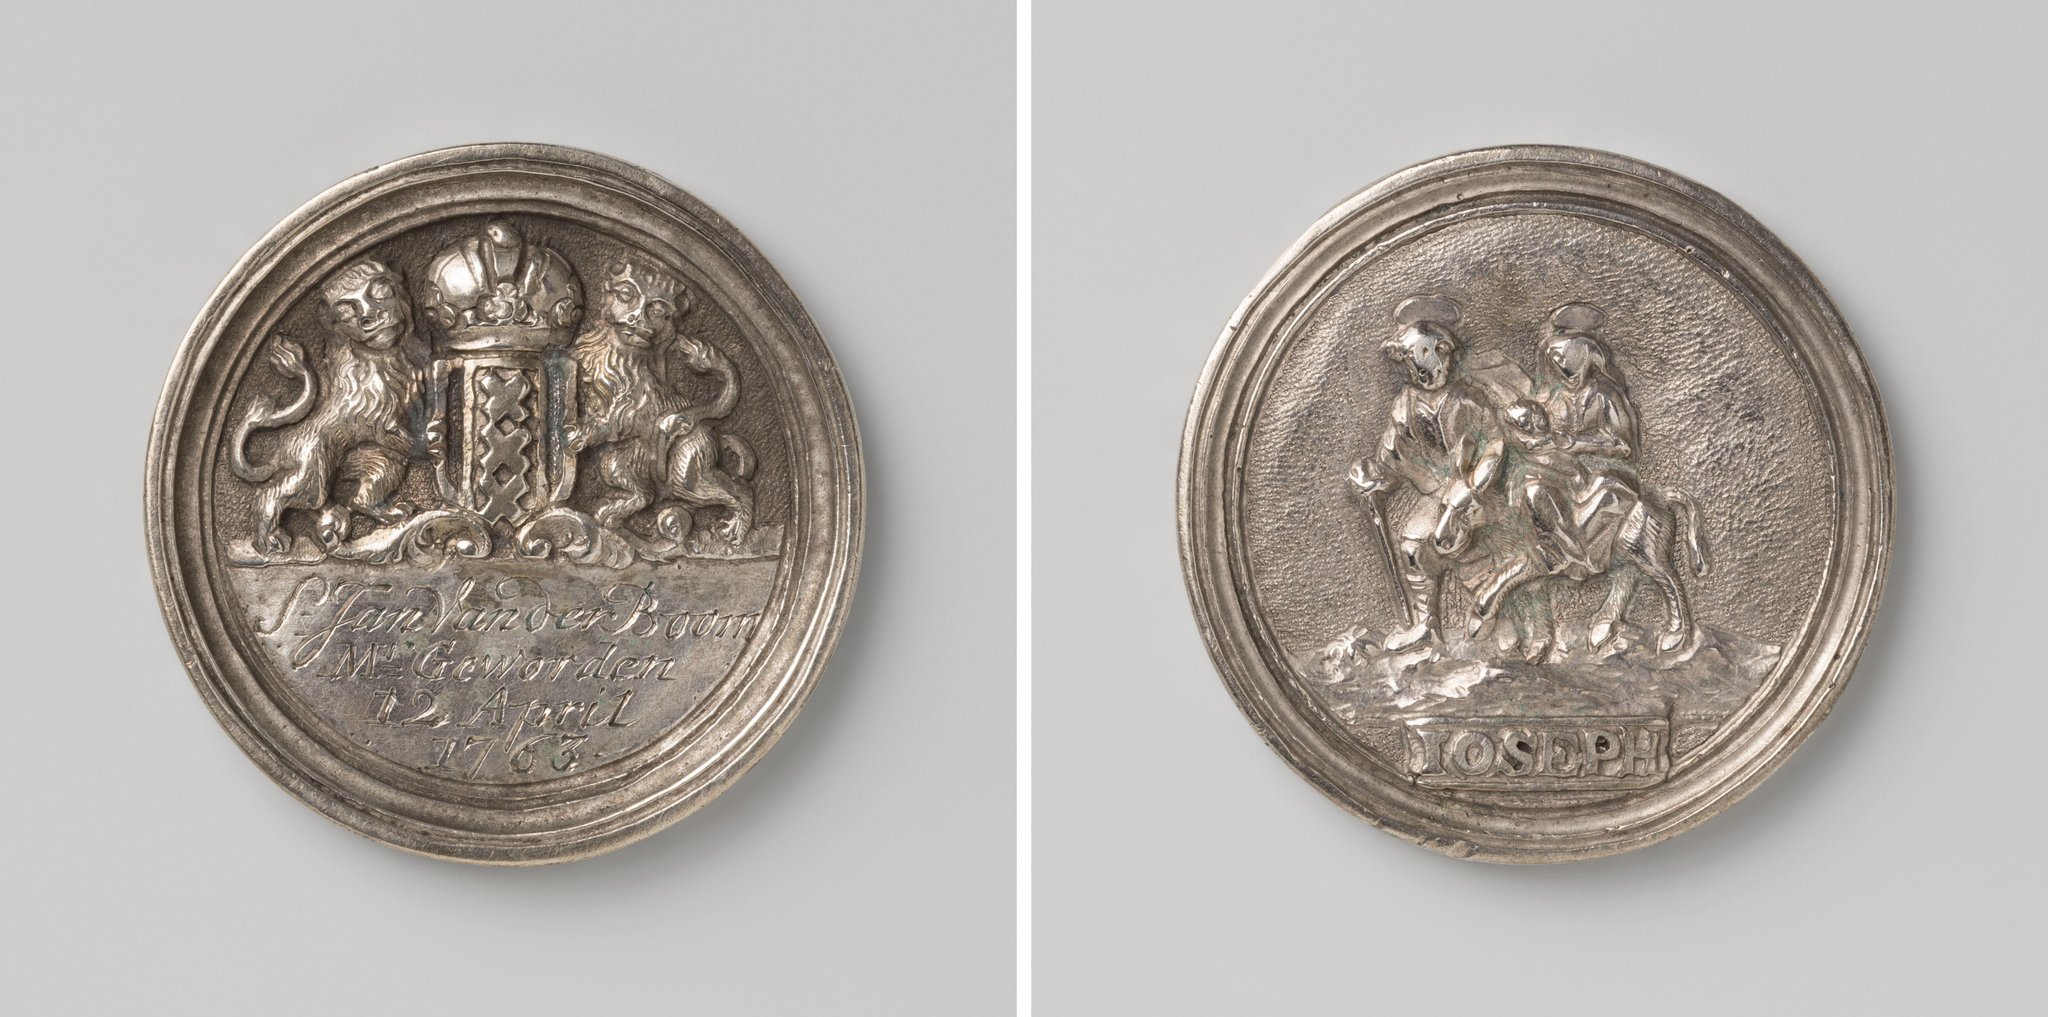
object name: medal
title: Timmerliedengilde van Amsterdam, gildepenning S. Jan van der Boom, overman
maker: Anonymous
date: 1763-1785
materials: silver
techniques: casting, engraving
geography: amsterdam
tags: amsterdam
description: Guilds were urban organisations of people in specific occupations. The guild represented the interests of the profession. Each member had a token as proof of membership. The person’s name was engraved on one side of the token, often together with the arms of the guild or of the city in which it was based. The other side carried a motif signifying the occupation represented by the guild.